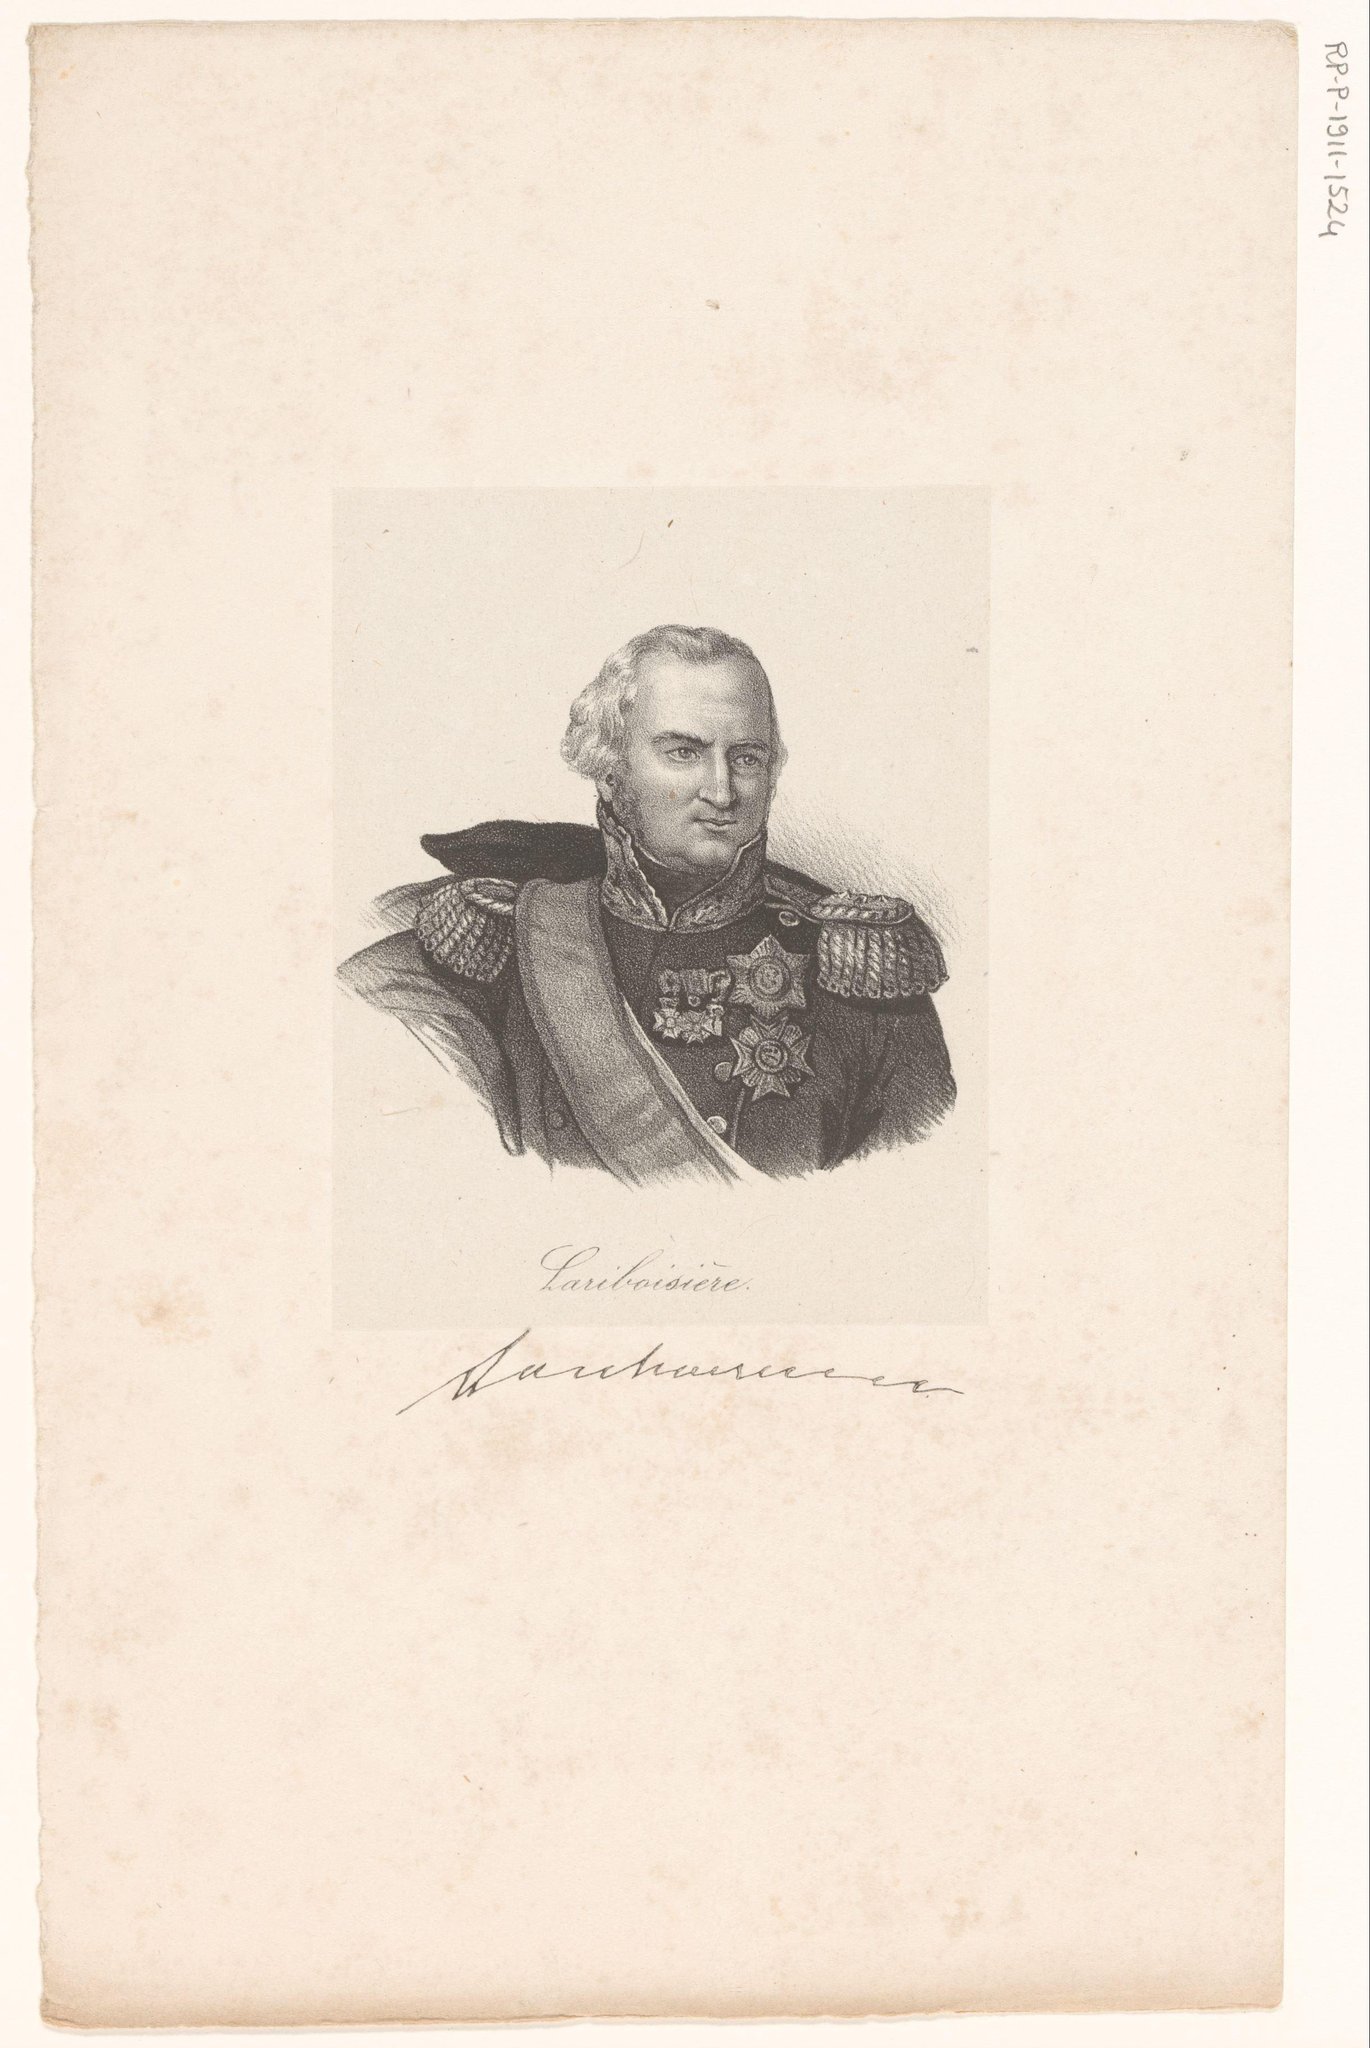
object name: print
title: Lariboisière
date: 1818-1842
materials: paper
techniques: lithograph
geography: paris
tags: historical persons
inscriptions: collector's mark: Lugt 2228a